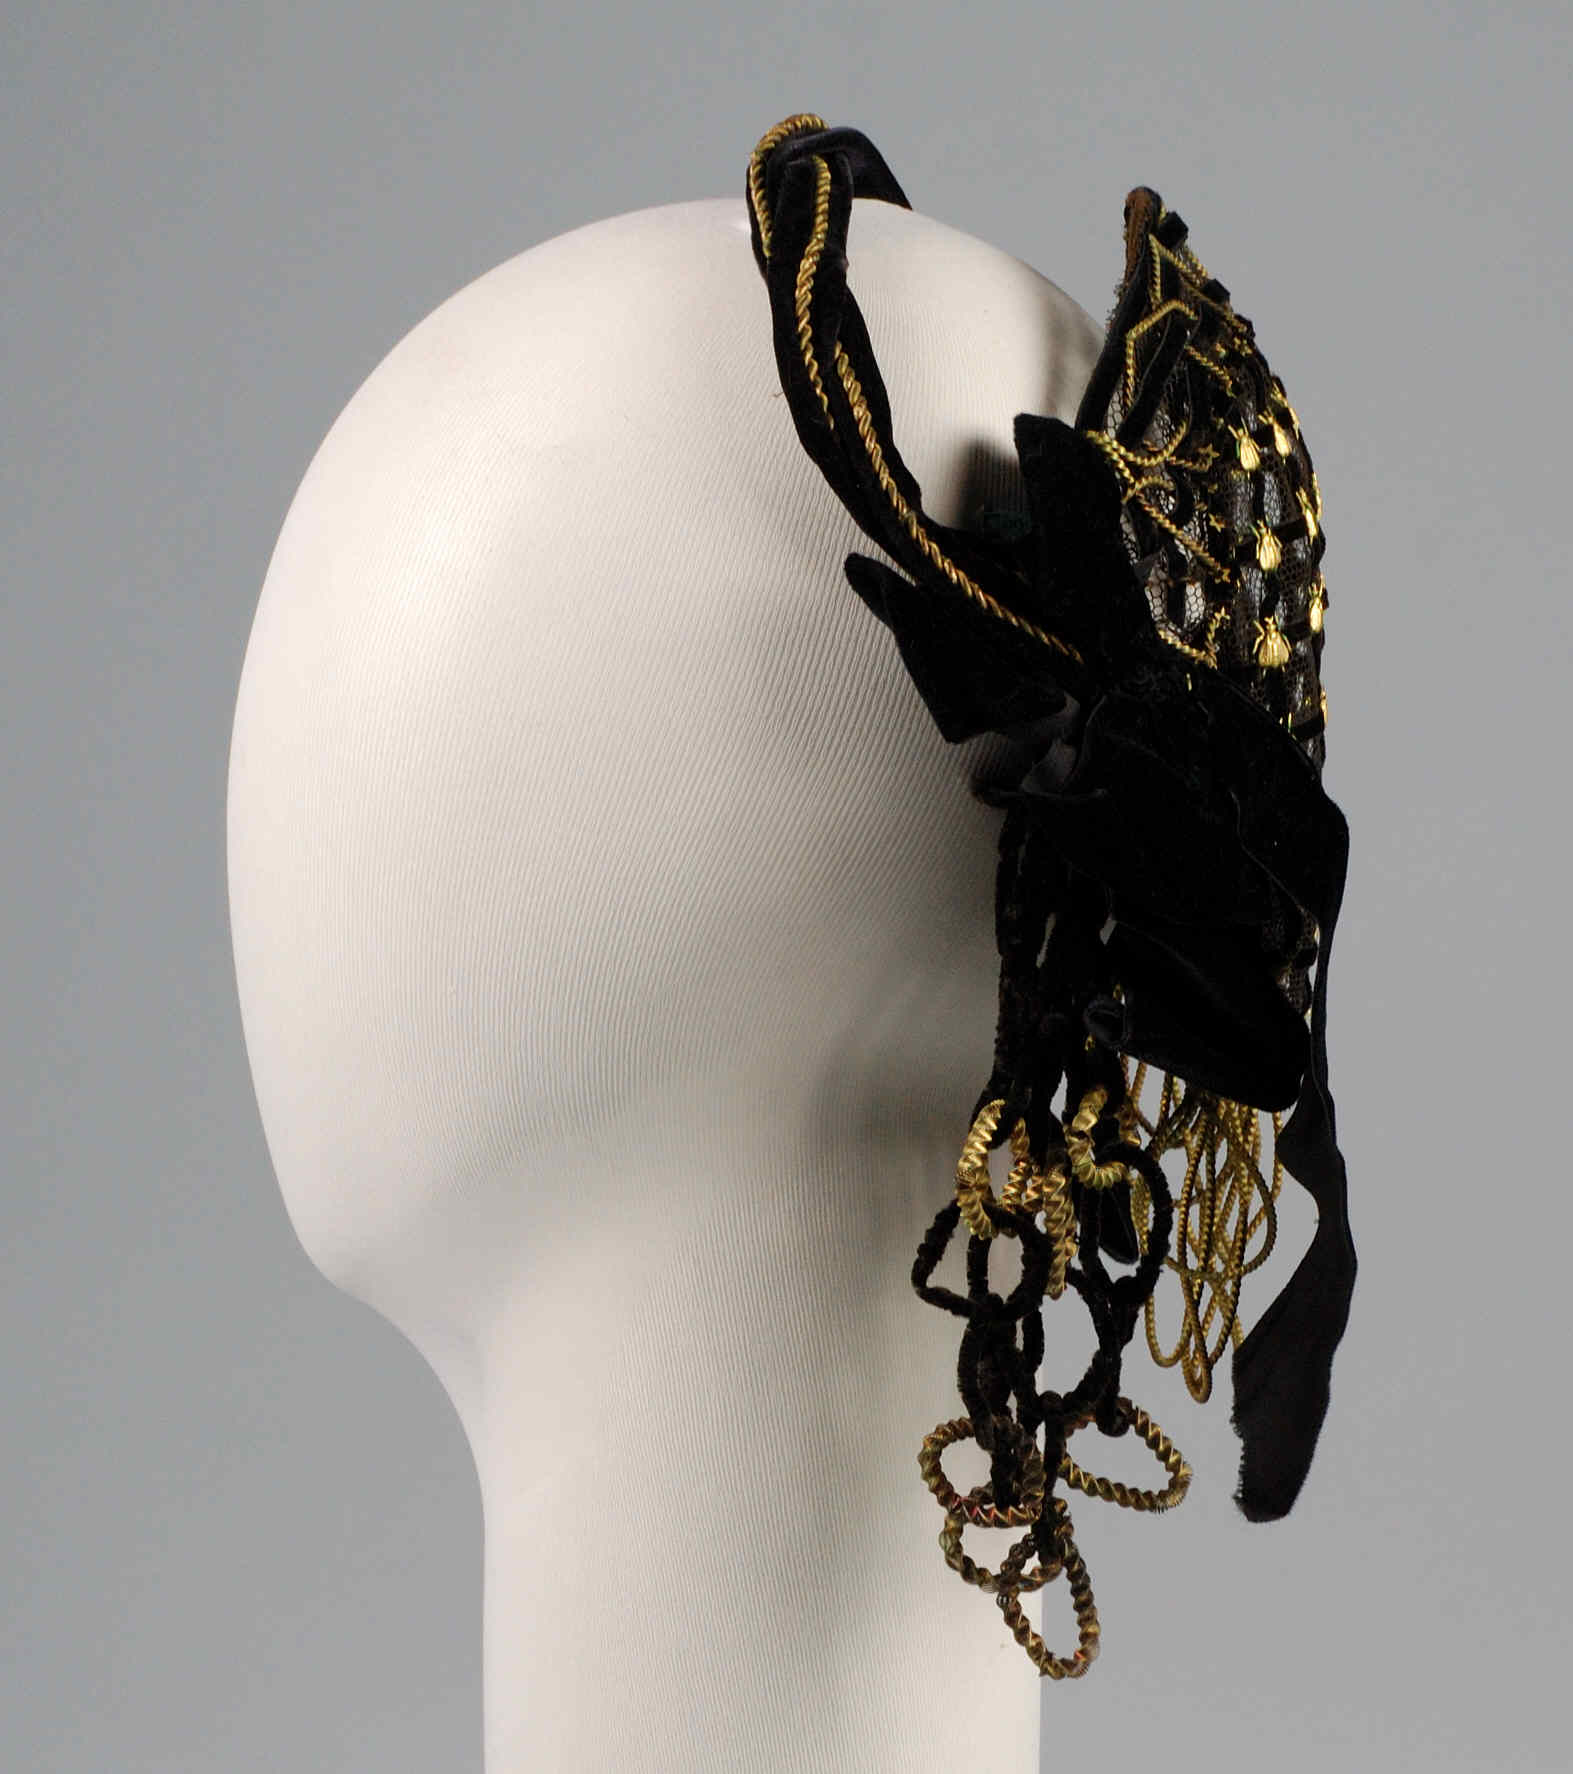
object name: evening headdress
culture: american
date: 1855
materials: metal, silk